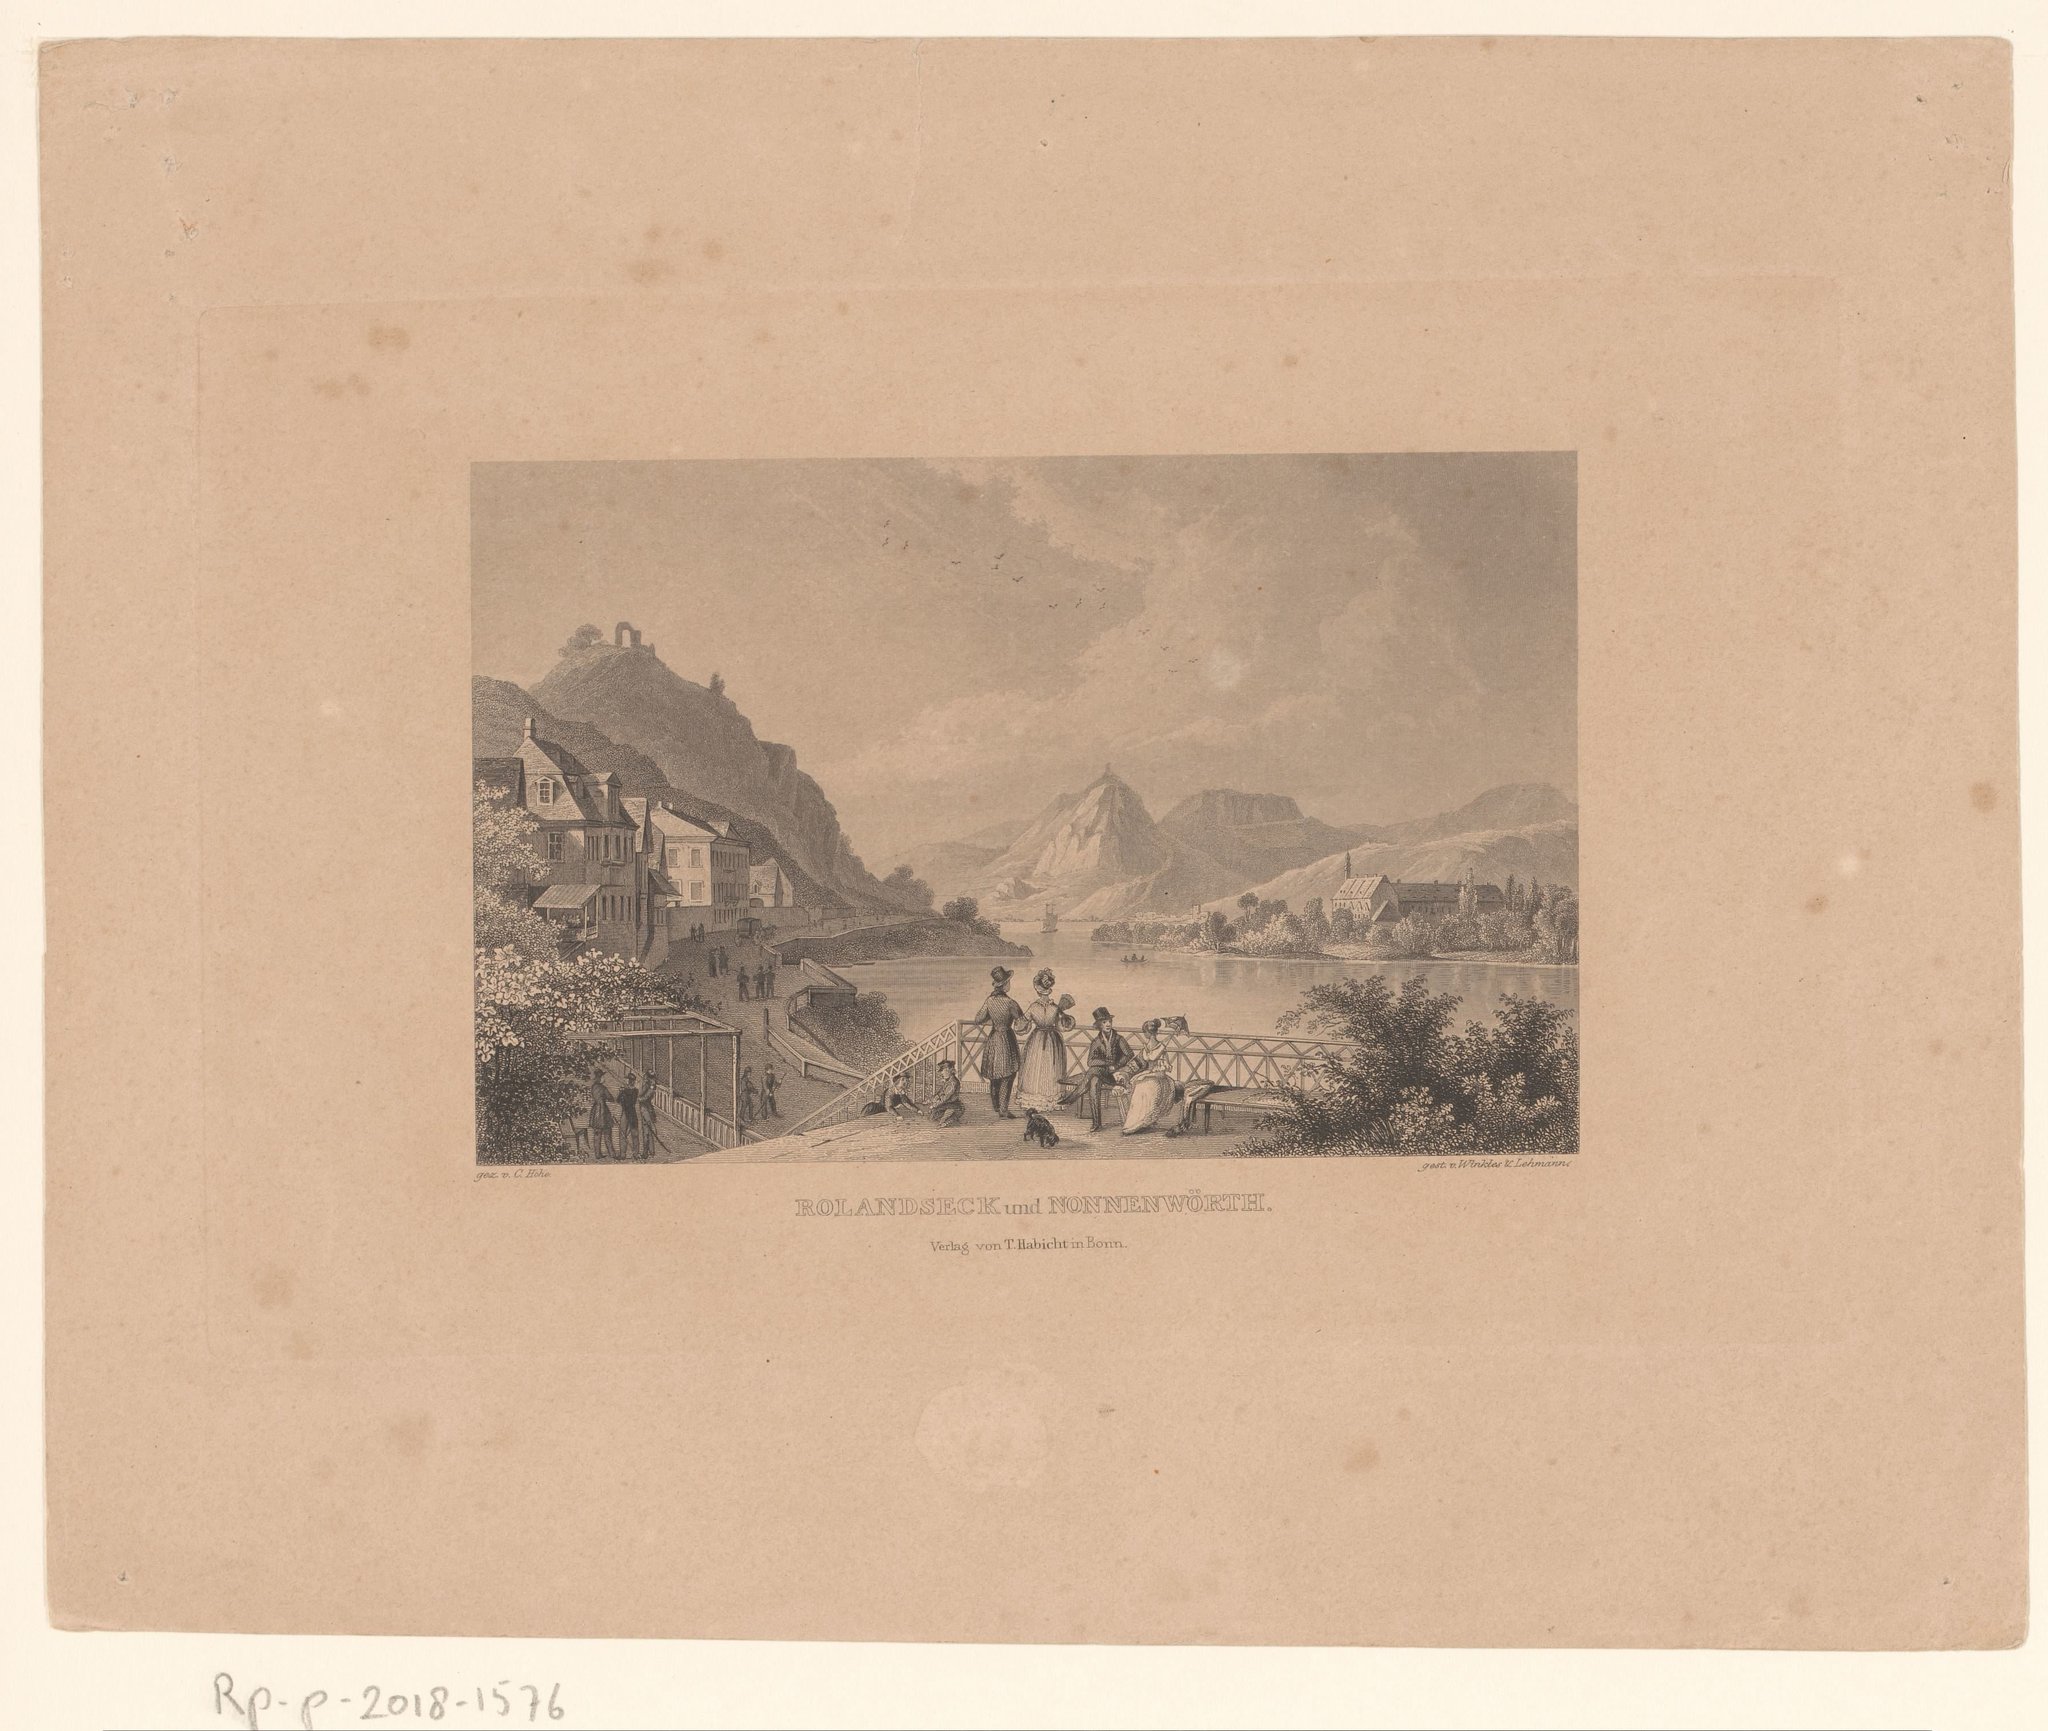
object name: print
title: Rolandseck und Nonnenwörth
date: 1800-1899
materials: paper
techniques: engraving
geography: bonn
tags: prospect of village, silhouette of village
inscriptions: collector's mark: Lugt 2228